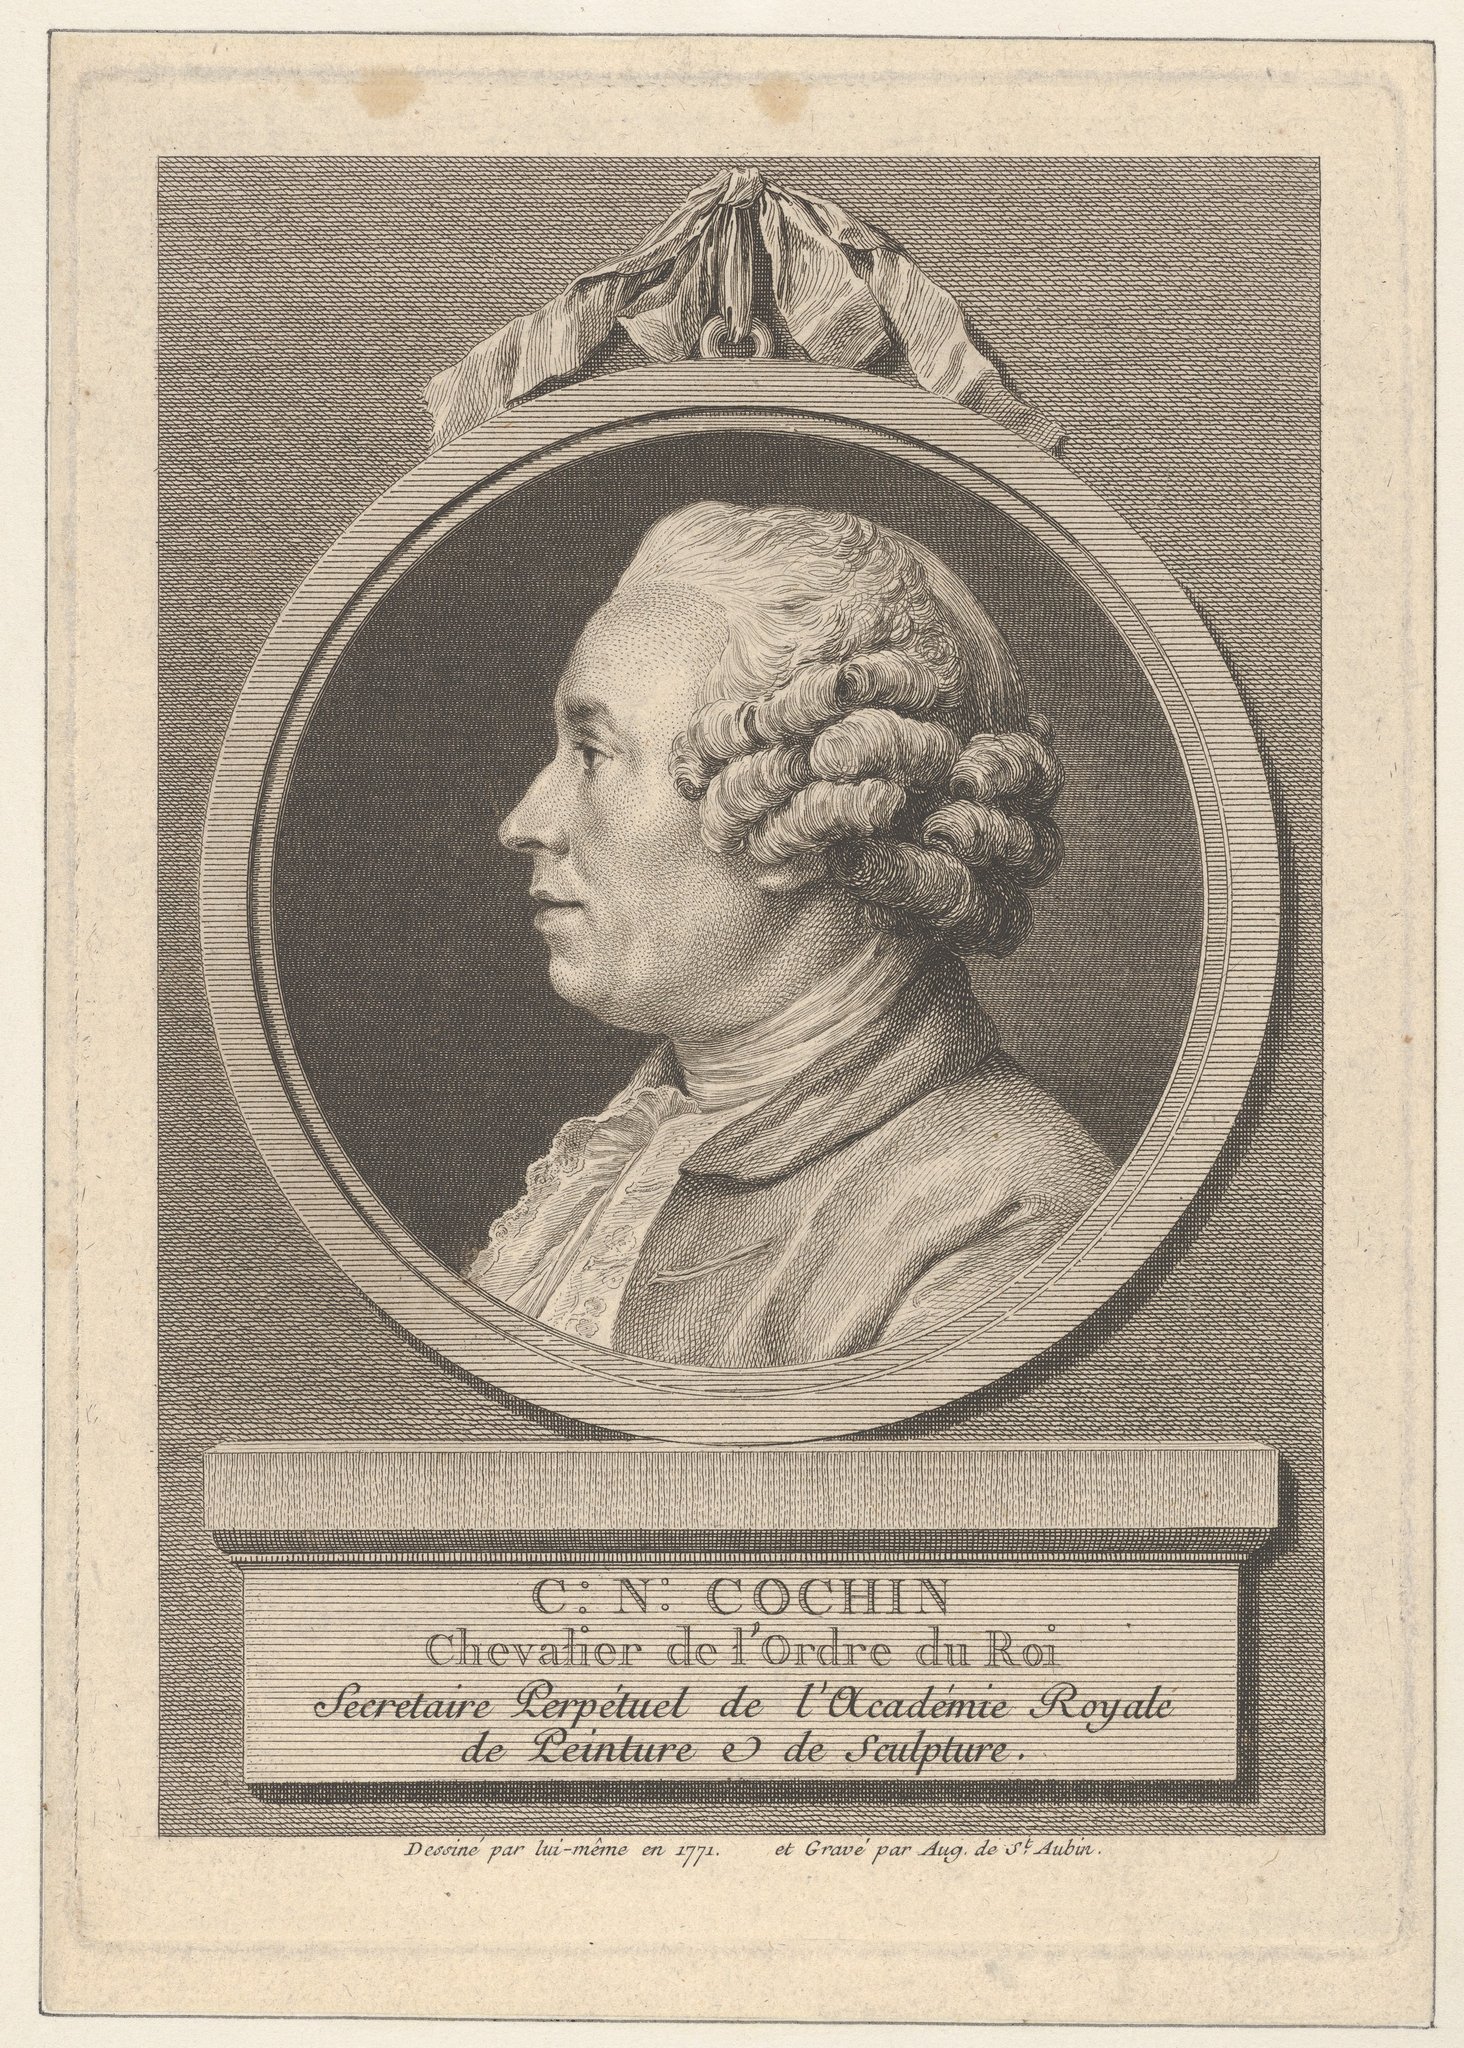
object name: print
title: Portrait of Charles-Nicolas Cochin II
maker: augustin de saint-aubin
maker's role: artist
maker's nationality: french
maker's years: 1736-1807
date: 1771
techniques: engraving, etching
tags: men,profiles